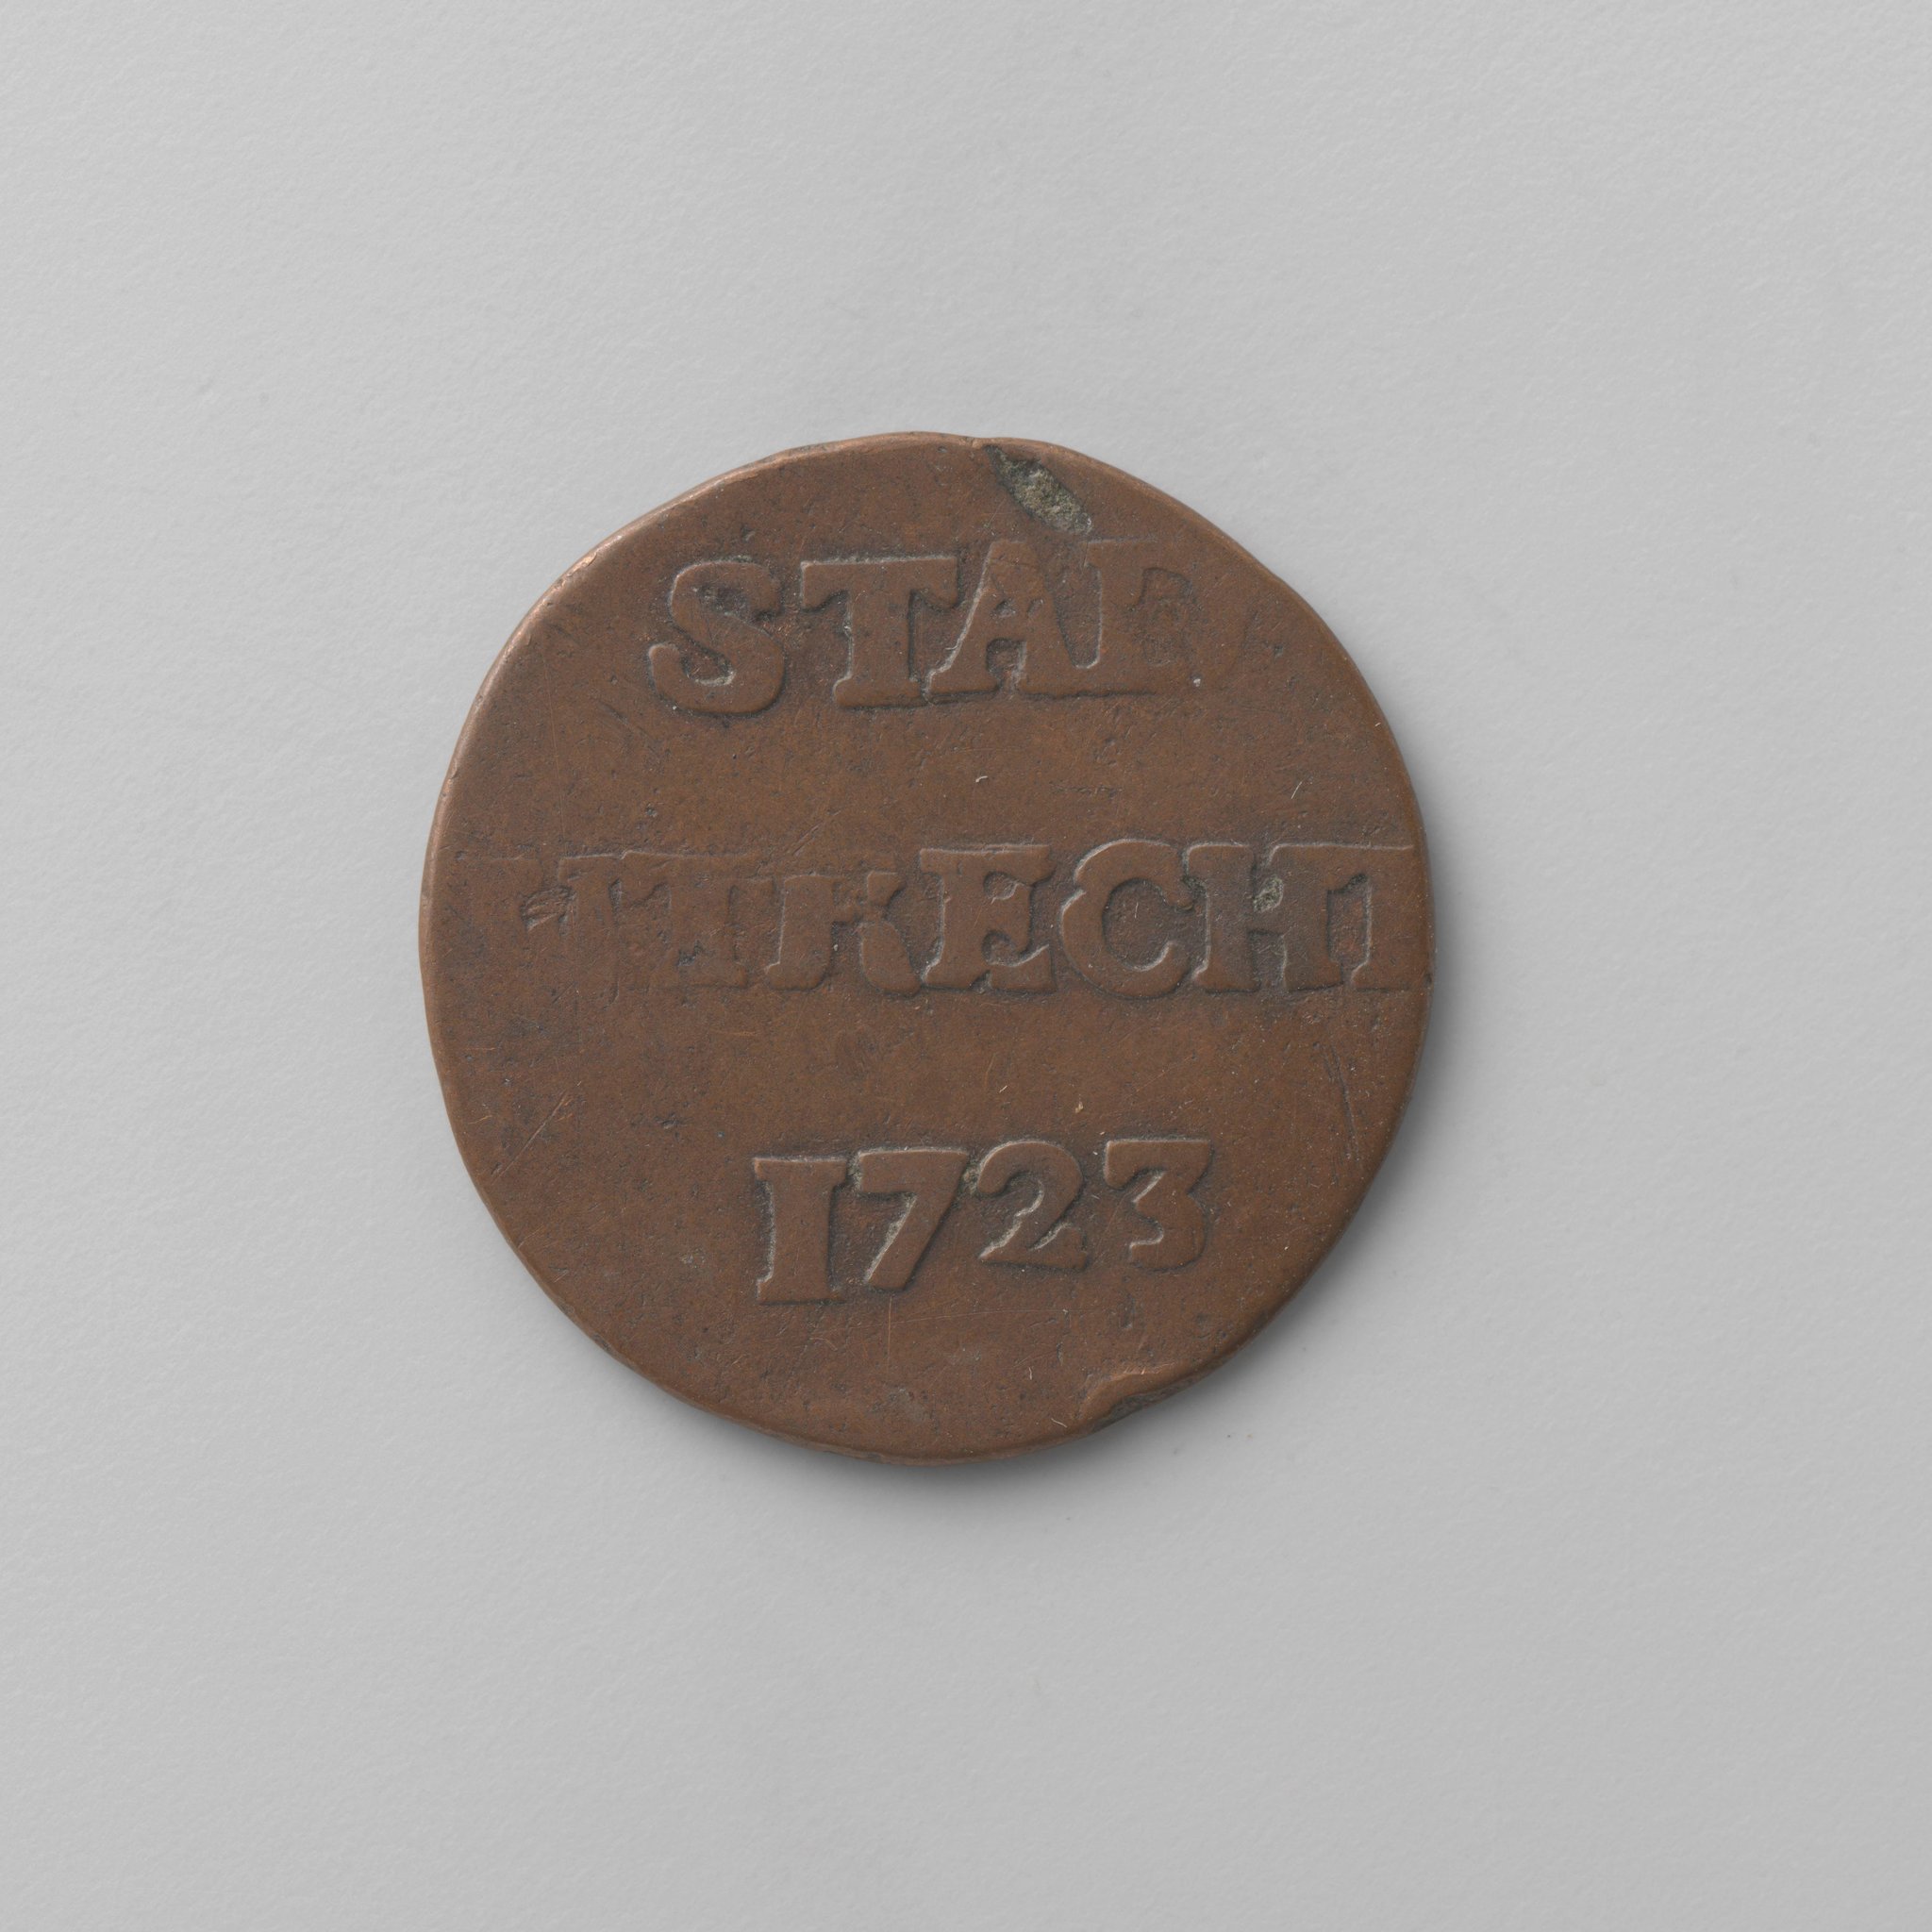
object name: coin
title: Stad Utrecht, duit, 1723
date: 1723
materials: copper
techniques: striking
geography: utrecht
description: Koperen munt. Voorzijde: gekroond stedelijk wapenschild. Keerzijde: opschrift in twee regels, waaronder jaartal.